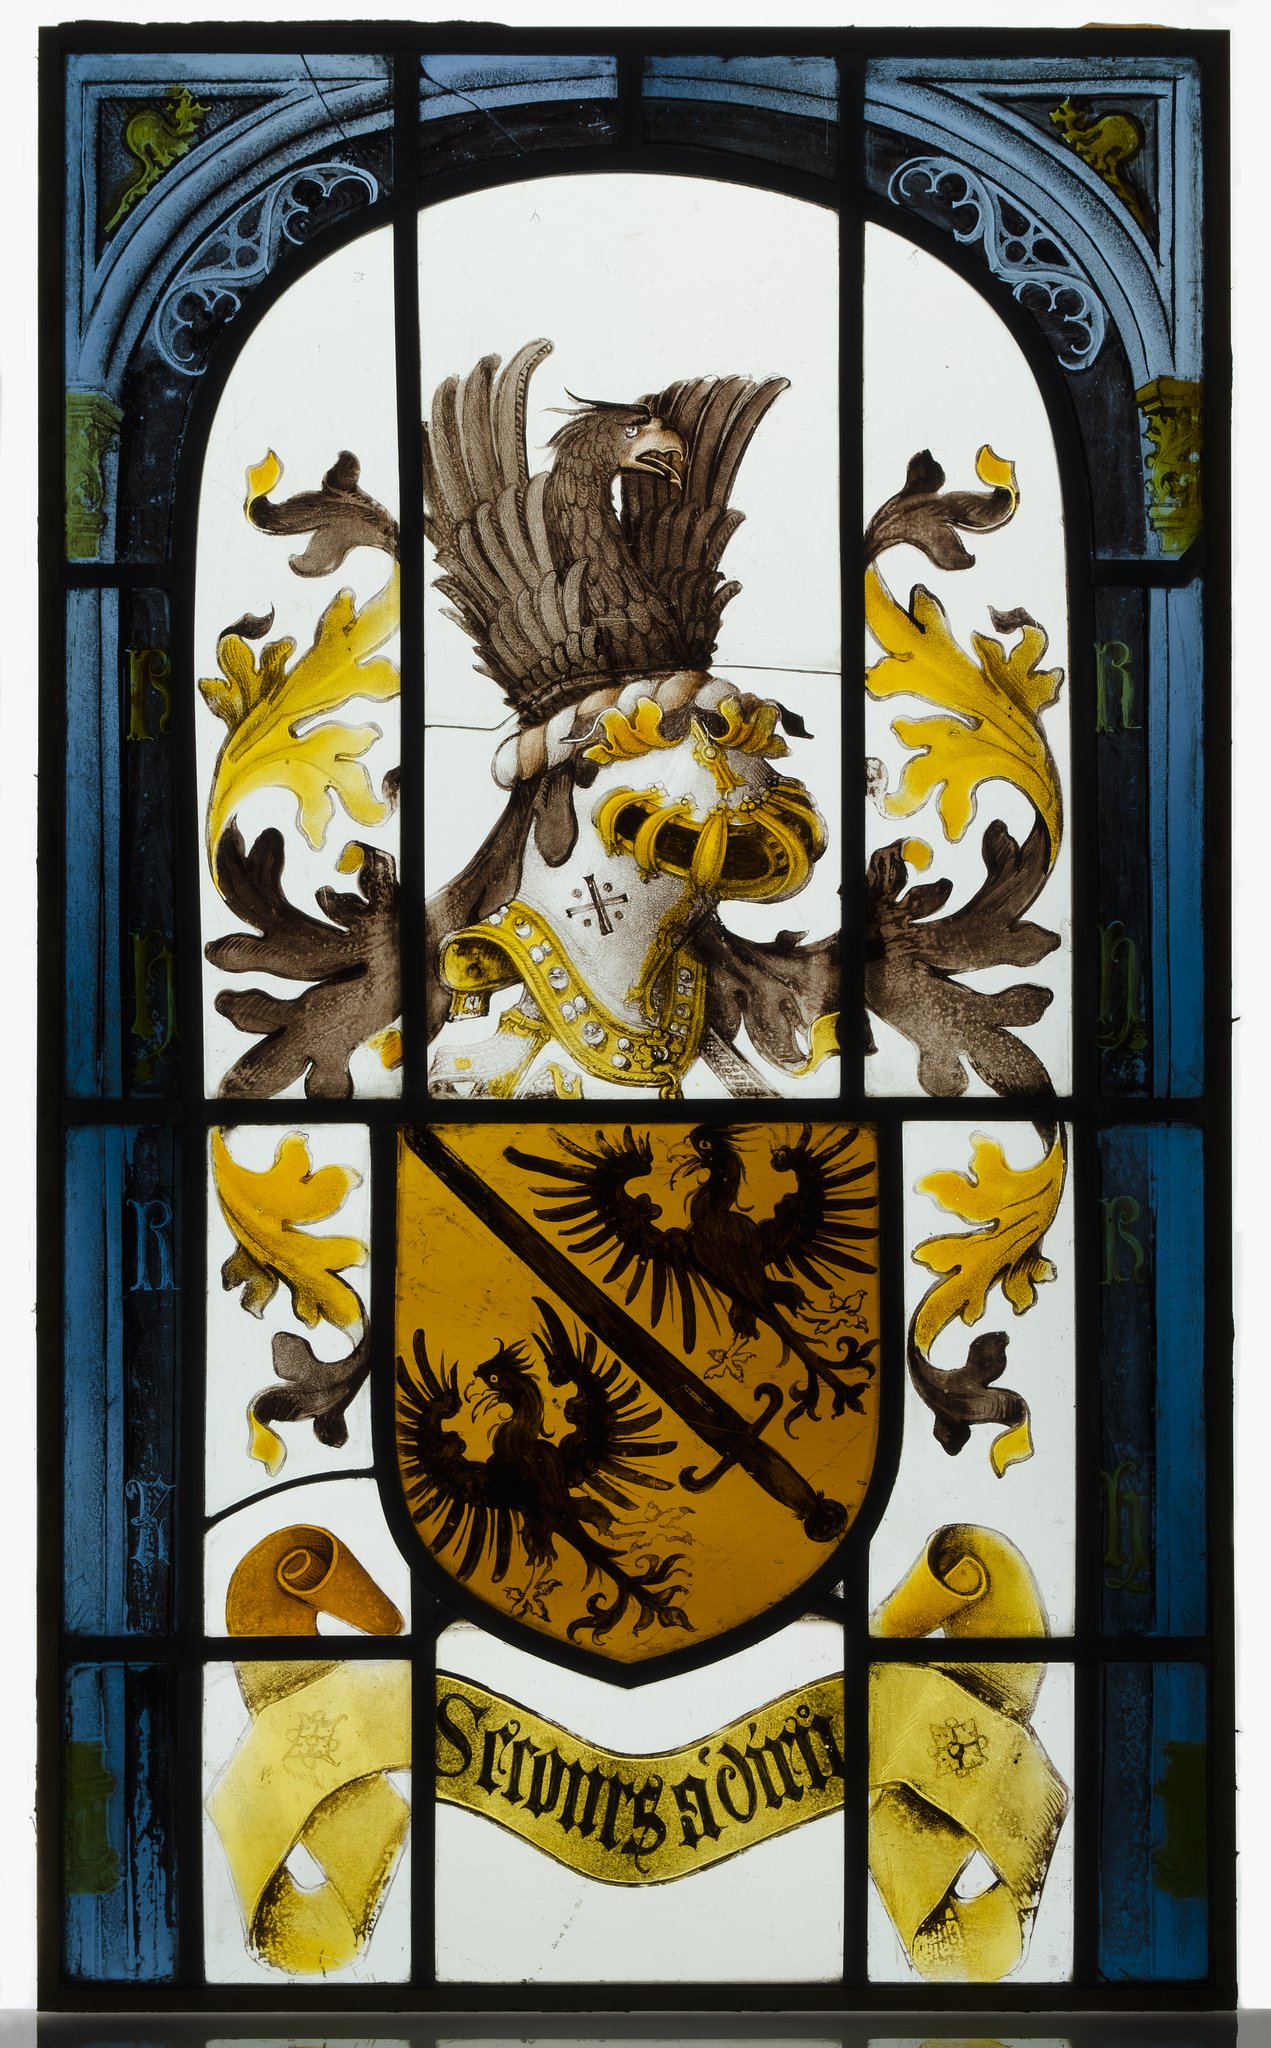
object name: panel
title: Heraldic Panel with Arms of the House of Hapsburg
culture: south netherlandish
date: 1504-1506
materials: glass, metal, paint, pigment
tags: coat of arms